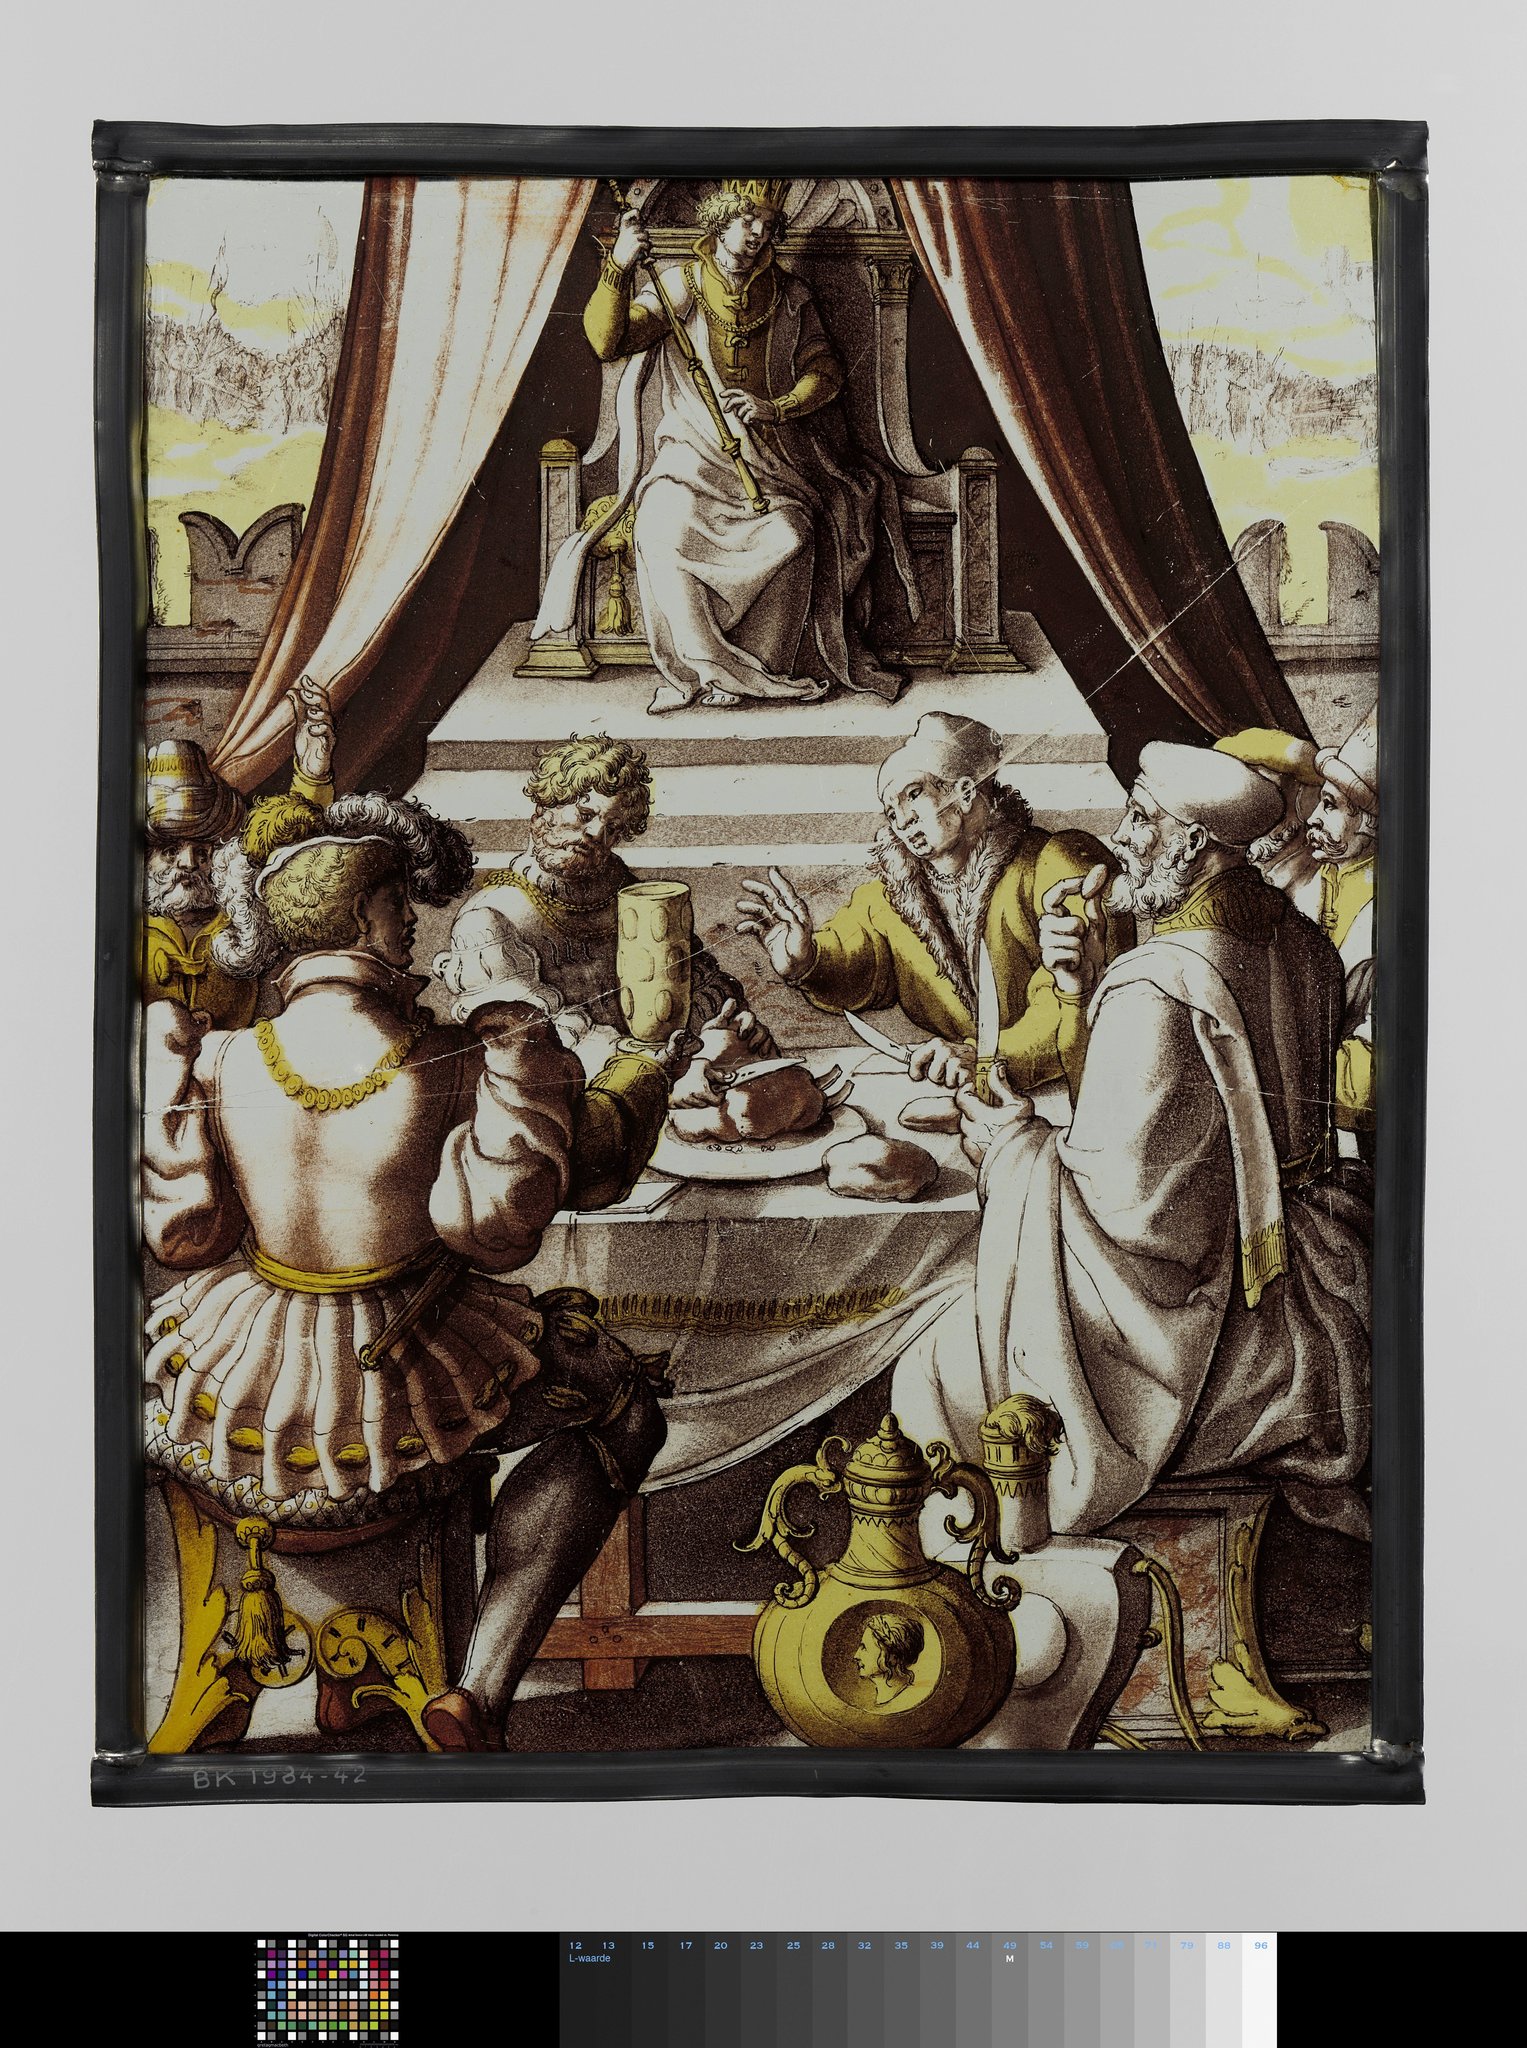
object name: light window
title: Het zondige Jeruzalem voor zijn verwoesting (?)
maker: Anonymous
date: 1540-1545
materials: glass, lead, pigment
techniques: leading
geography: northern netherlands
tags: story of solomon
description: Banquet with a king enthroned. Stained glass. Netherlands, c. 1540, after Jan Swart van Groningen (before 1500 - c. 1560).